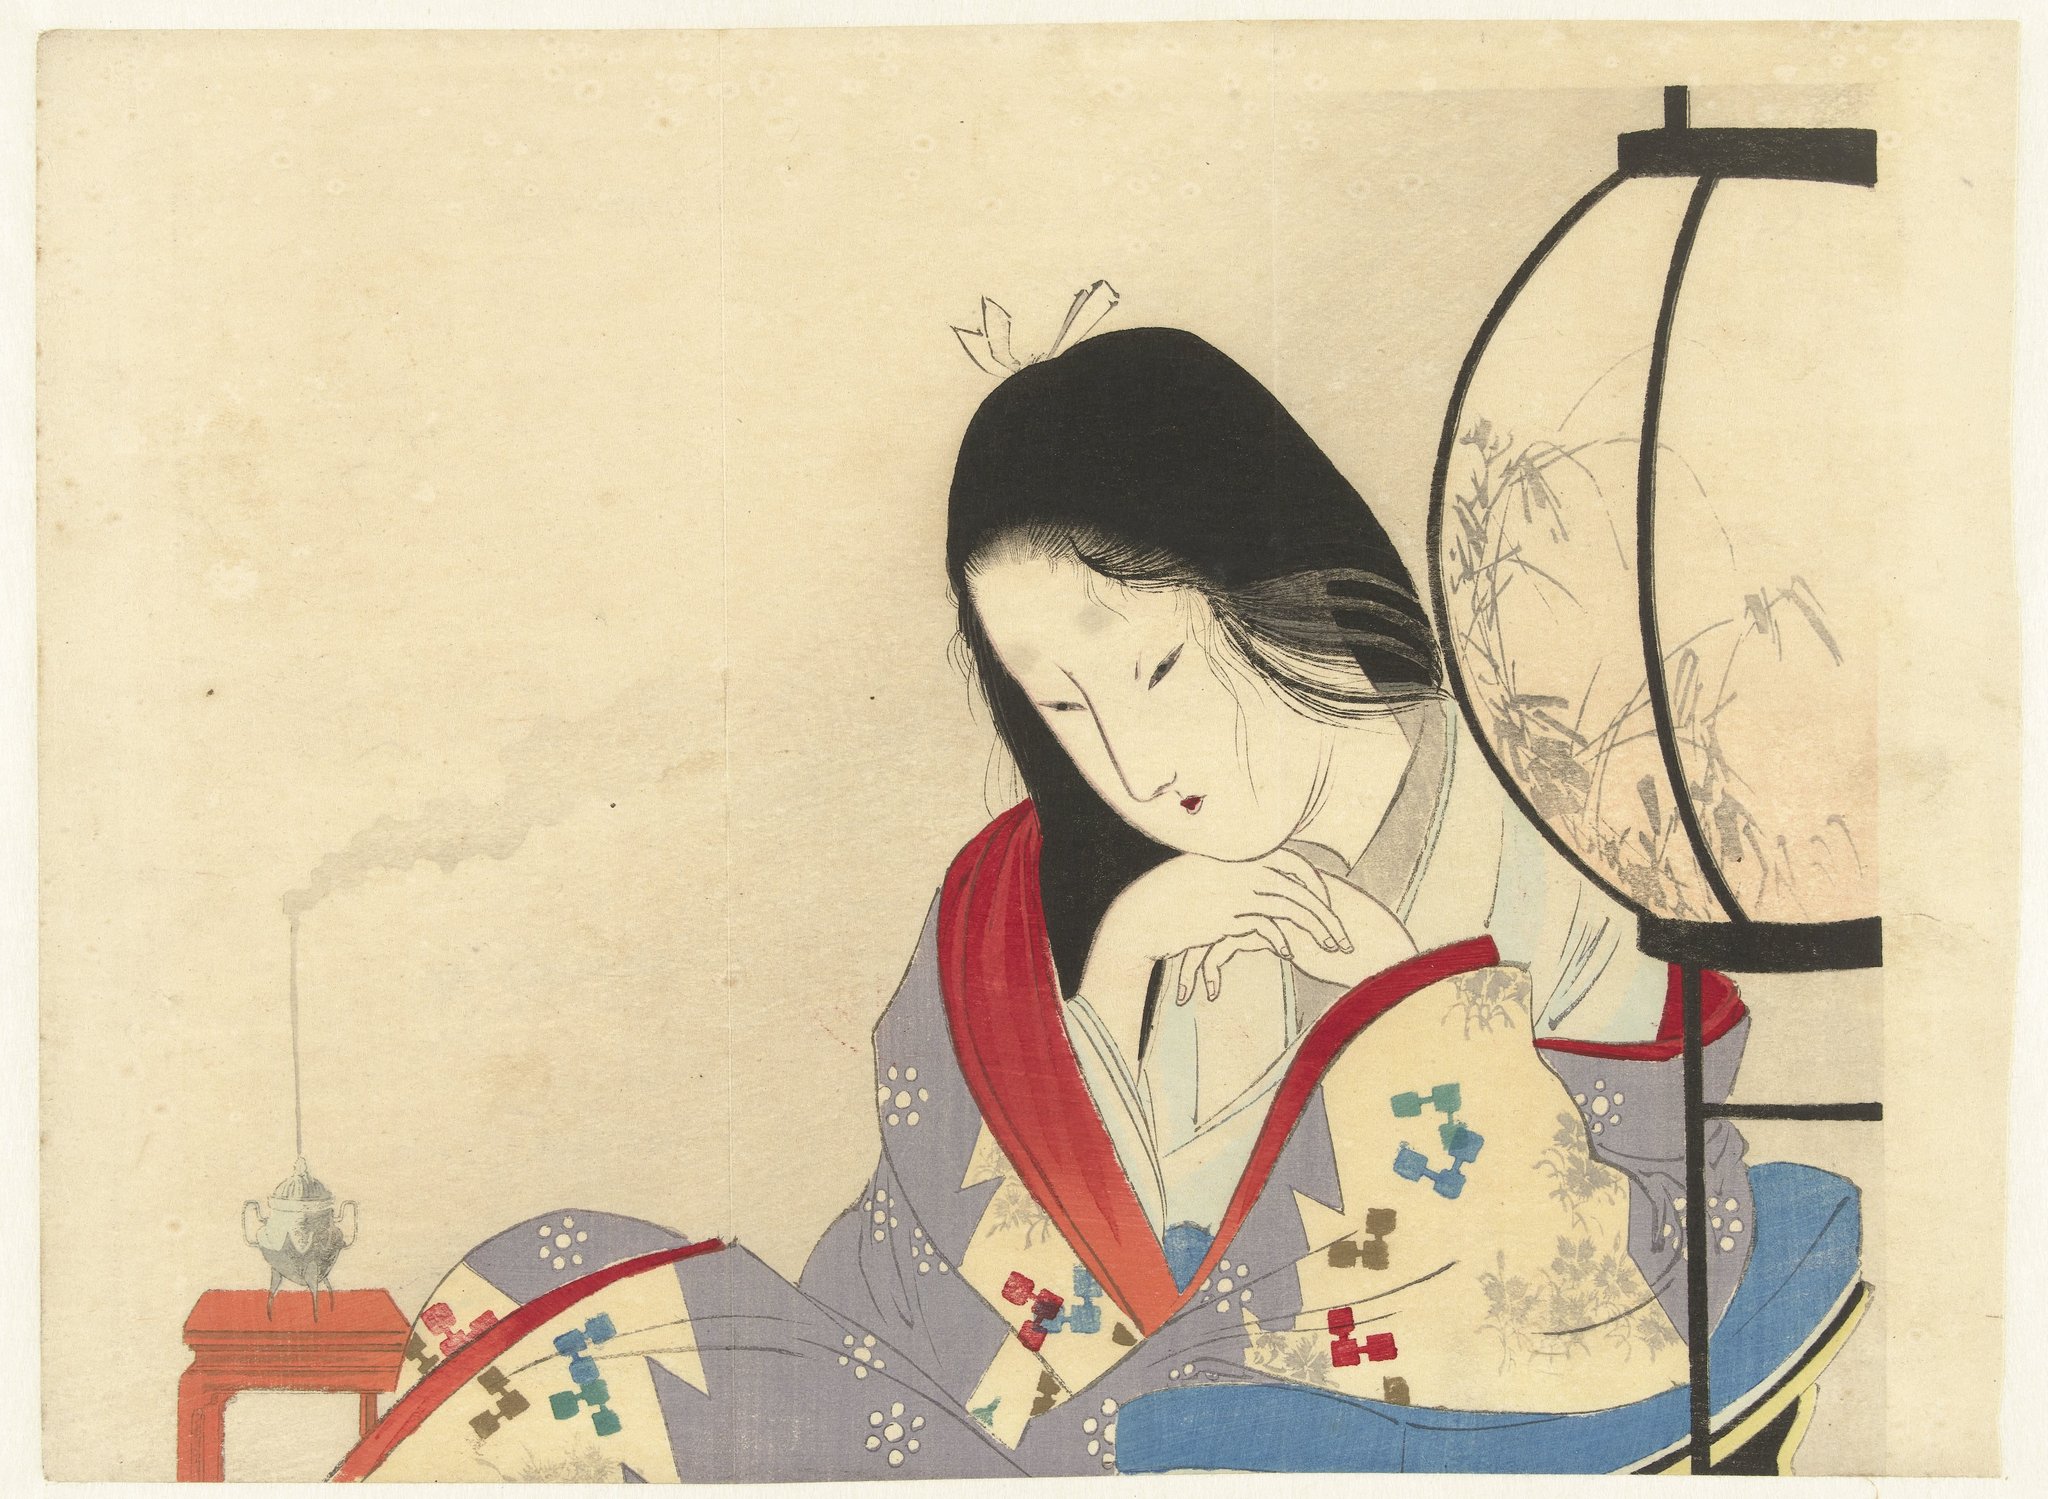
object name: kuchi e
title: Vrouw bij een lamp in interieur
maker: mizuno toshikata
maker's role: print maker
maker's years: 1866-1908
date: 1890-1908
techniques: woodcut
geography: japan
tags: adult woman, lighting; lamps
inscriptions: collector's mark: Lugt 2760, collector's mark: Lugt 2228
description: Vrouw in peinzende houding, zittend naast een Japanse lantaarn; rechts van haar een wierookvaatje op een klein tafeltje.